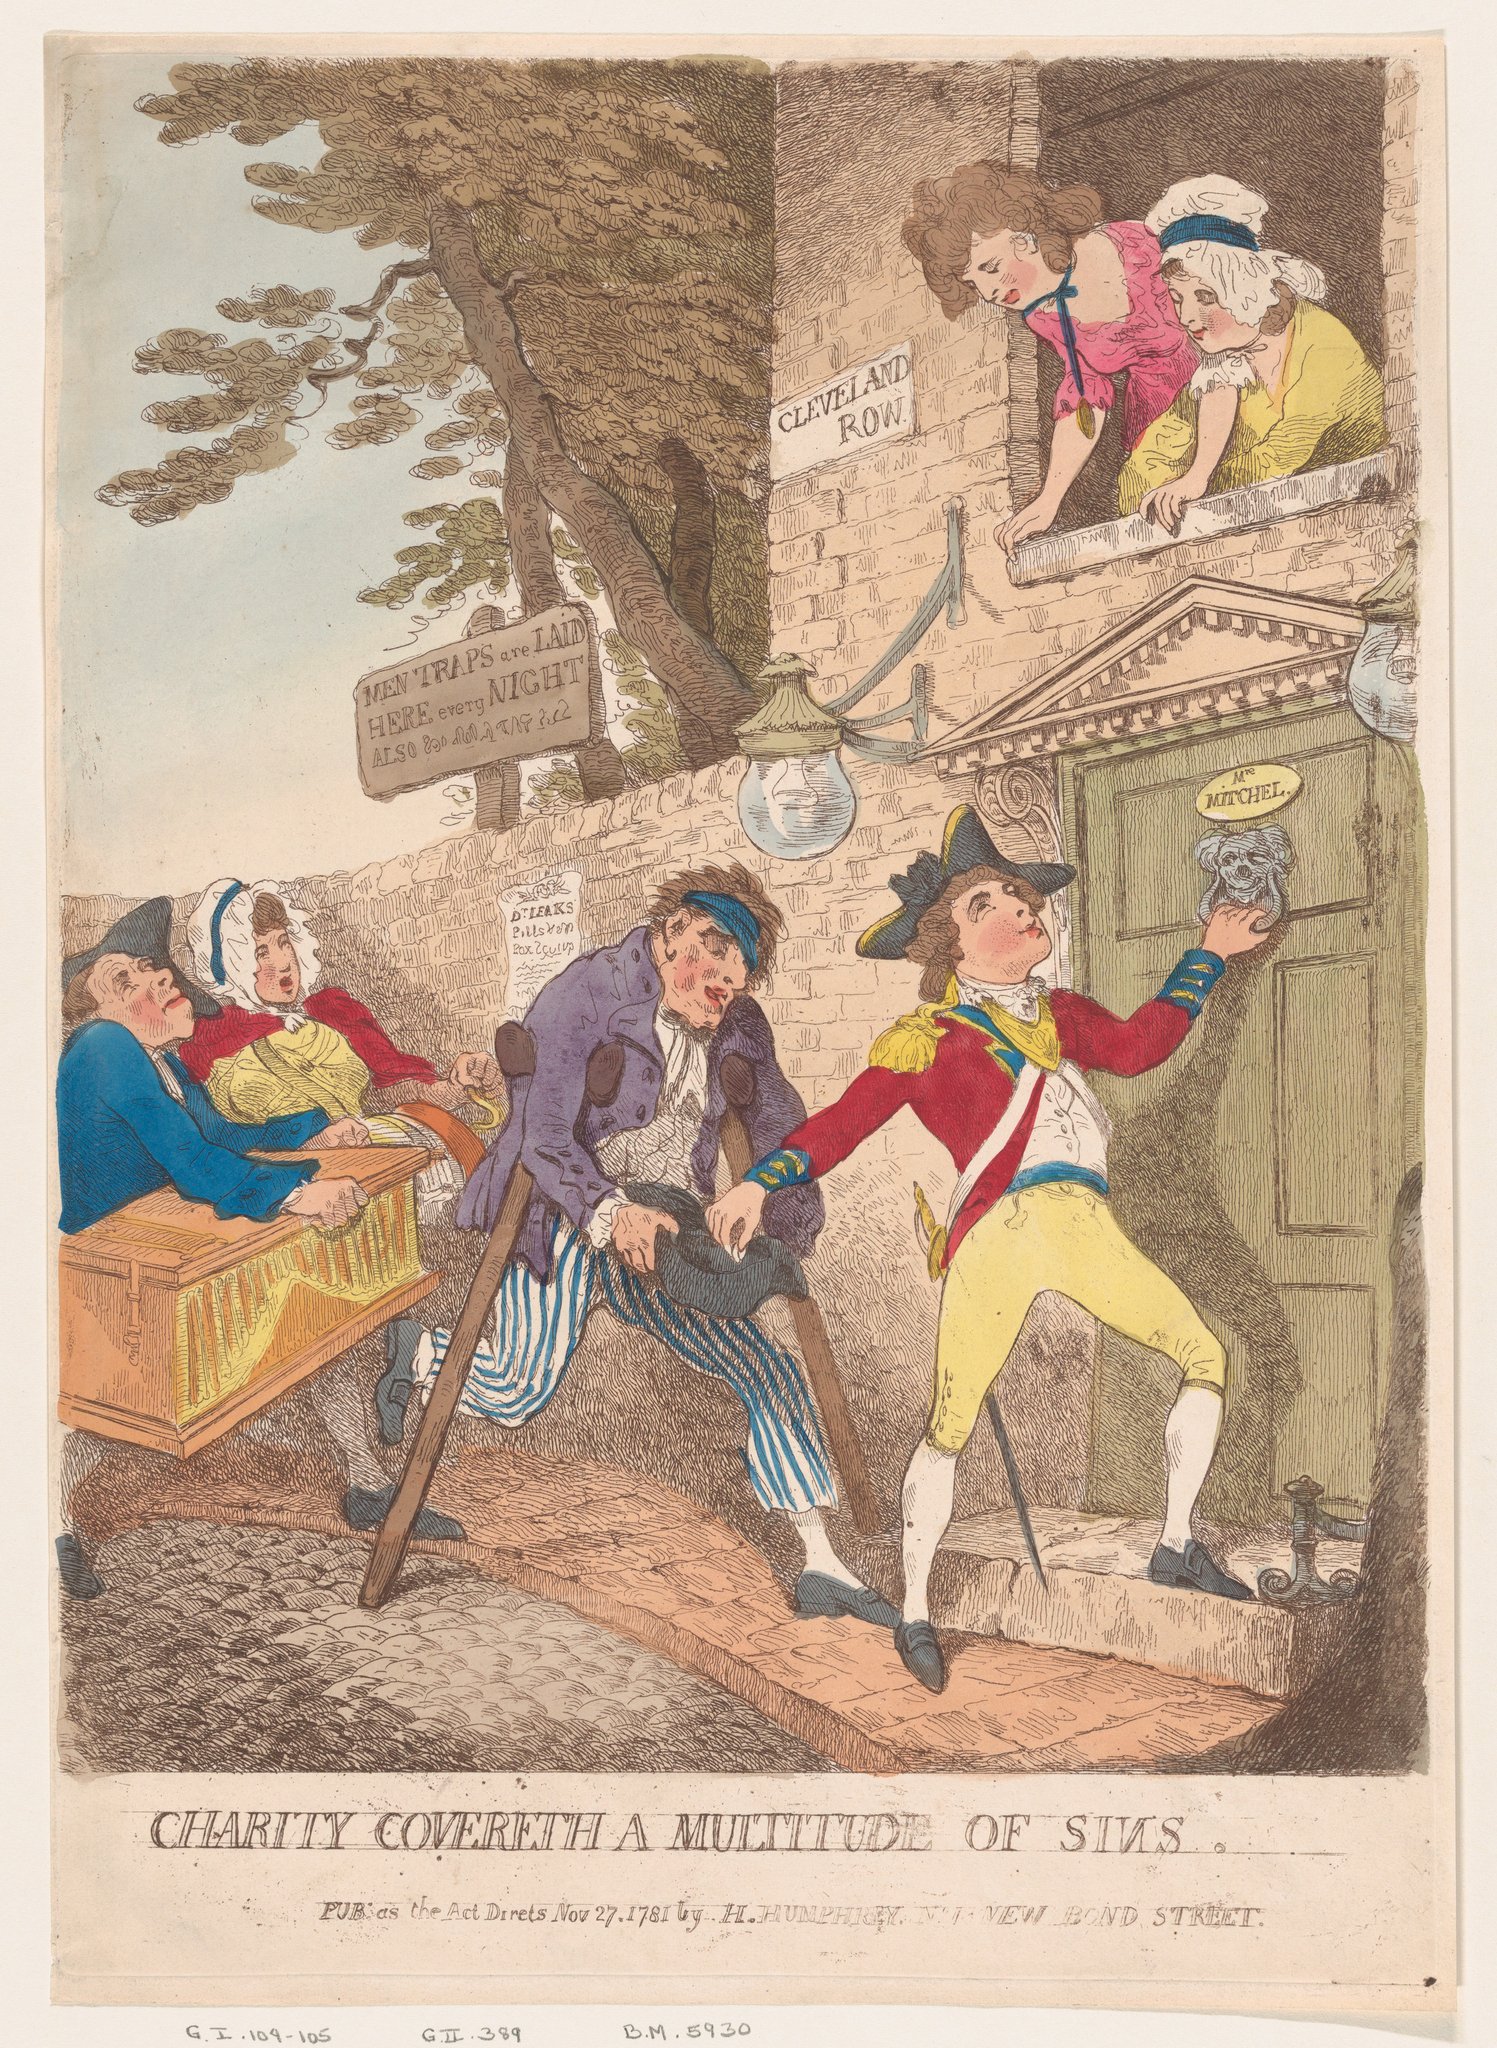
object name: print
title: Charity Covereth a Multitude of Sins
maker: thomas rowlandson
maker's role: artist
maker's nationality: british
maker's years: 1757-1827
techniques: etching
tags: satire,men,women